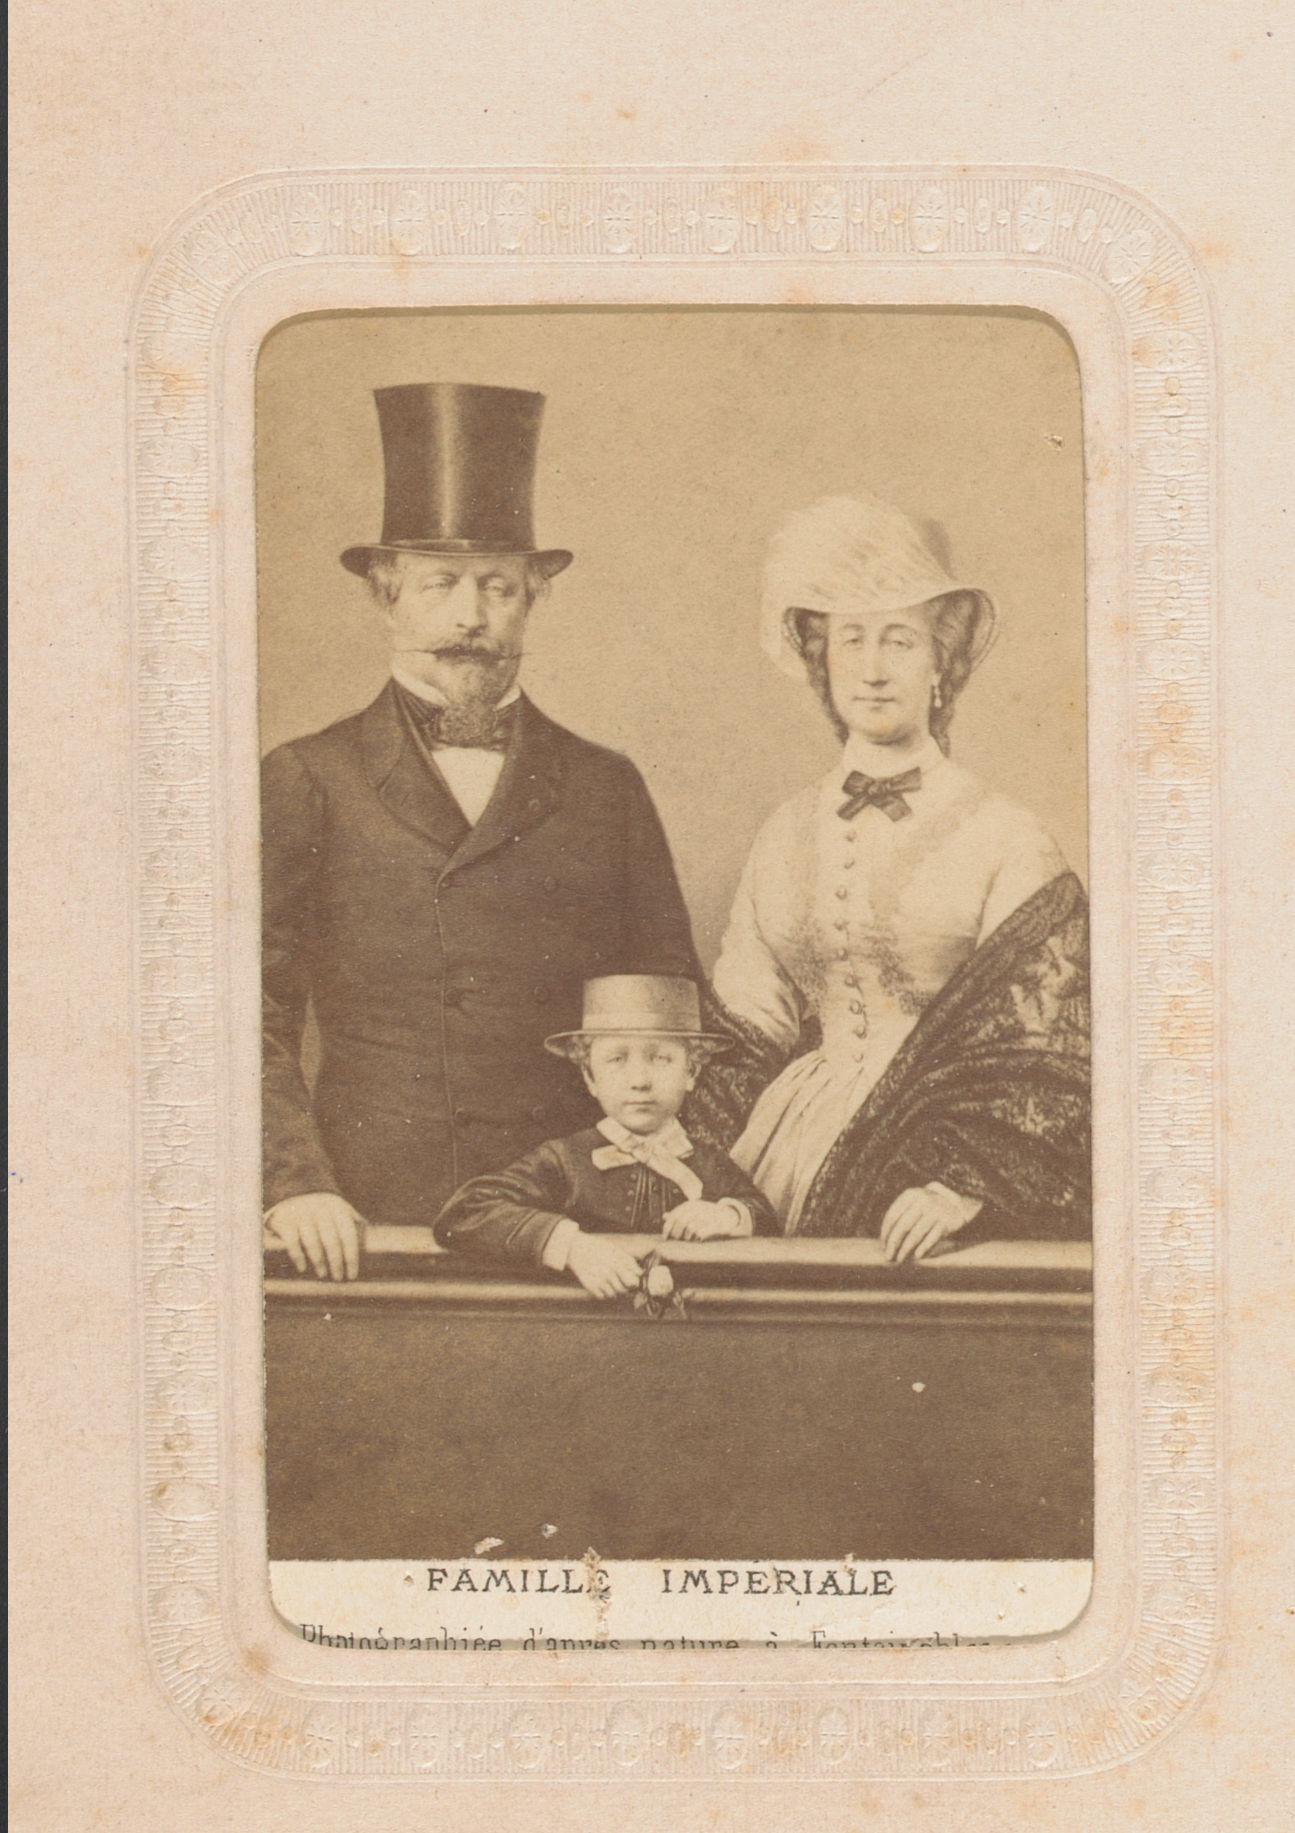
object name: album leaf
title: Fotoreproductie van een familieportret van een koninklijke familie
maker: Anonymous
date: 1855-1865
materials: cardboard, photographic support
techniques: albumen print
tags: family of the sovereign, anonymous historical persons portrayed in a group, in a group-portrait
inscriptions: inscription: ‘Famille Impériale/ Photographiée d'apres nature à Fontainbleau’